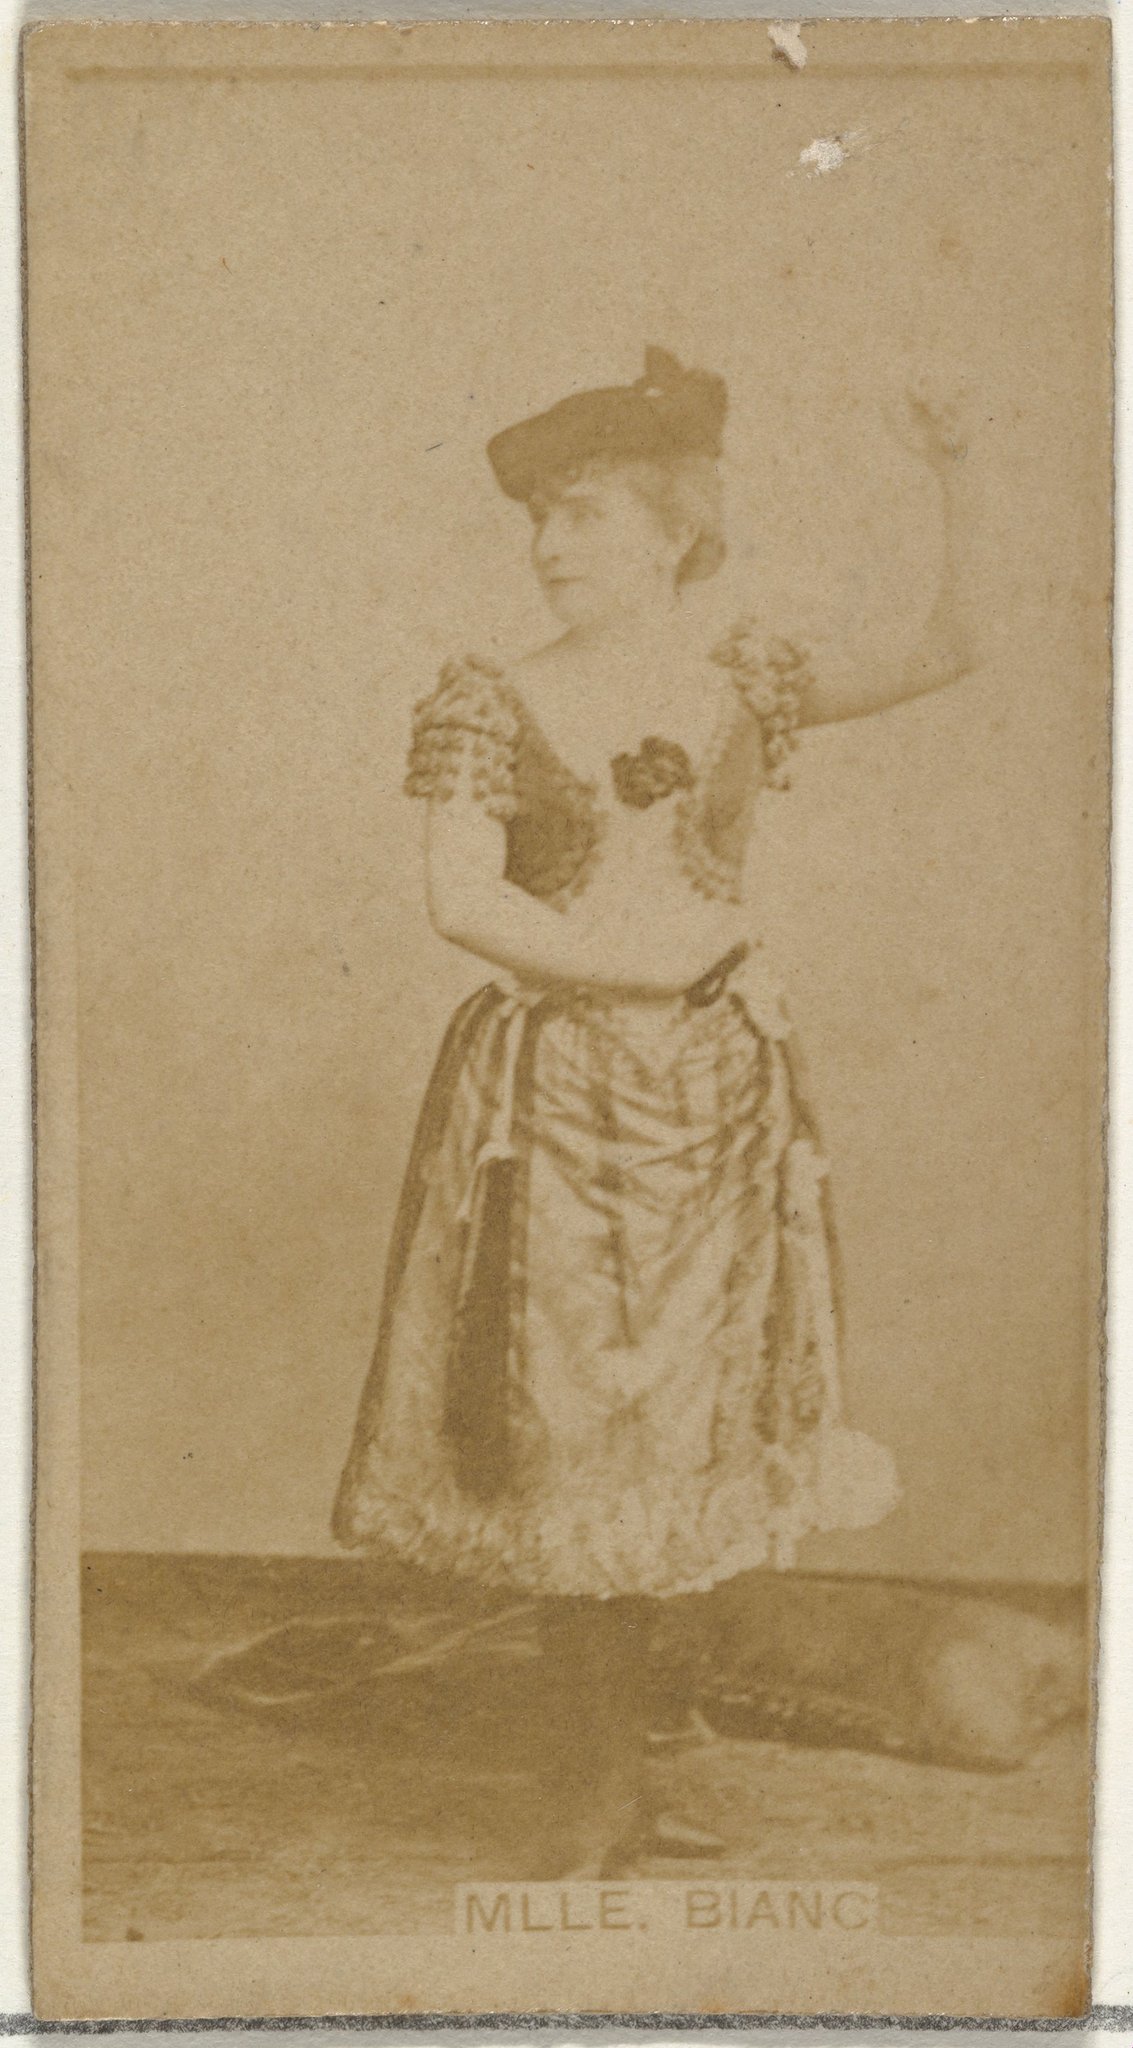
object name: photograph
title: Mlle. Bianc, from the Actors and Actresses series (N145-8) issued by Duke Sons & Co. to promote Duke Cigarettes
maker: w. duke, sons & co.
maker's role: publisher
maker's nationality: american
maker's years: 1870-1920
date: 1891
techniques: albumen silver print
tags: portraits,women,actresses